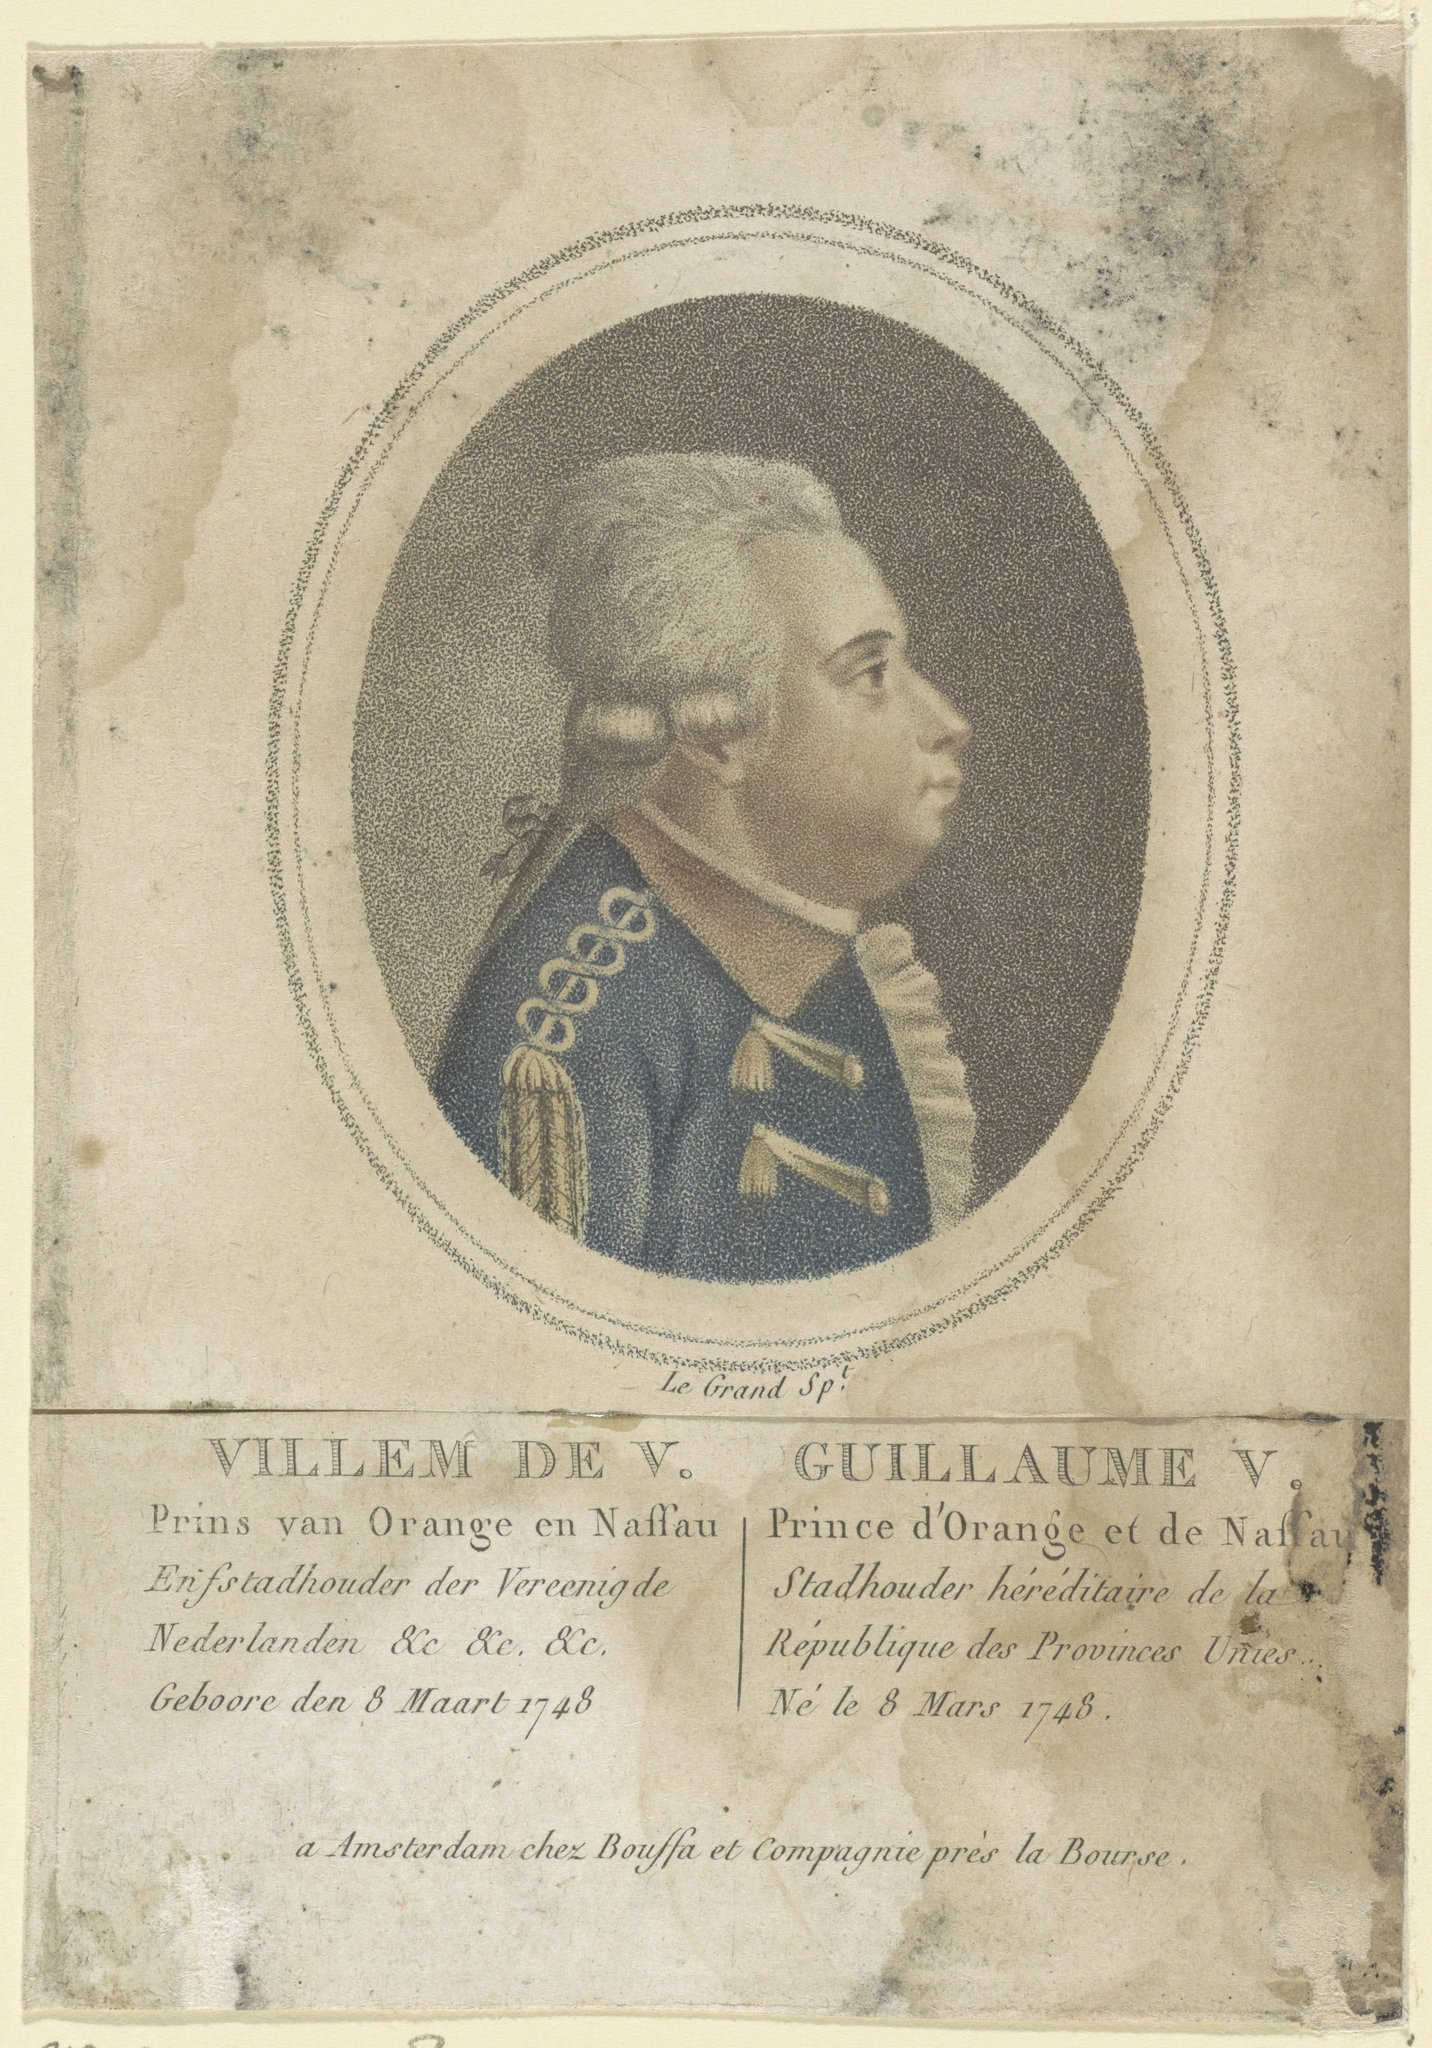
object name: print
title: Portret van Willem V, prins van Oranje-Nassau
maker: le grand (prentmaker)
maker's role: print maker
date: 1775-1849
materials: paper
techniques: engraving, etching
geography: amsterdam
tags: william v (prince of orange)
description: De hier vermelde titel verwijst naar de hoogst verkregen titel van de geportretteerde, niet per se naar de titel die de geportretteerde op deze voorstelling draagt.